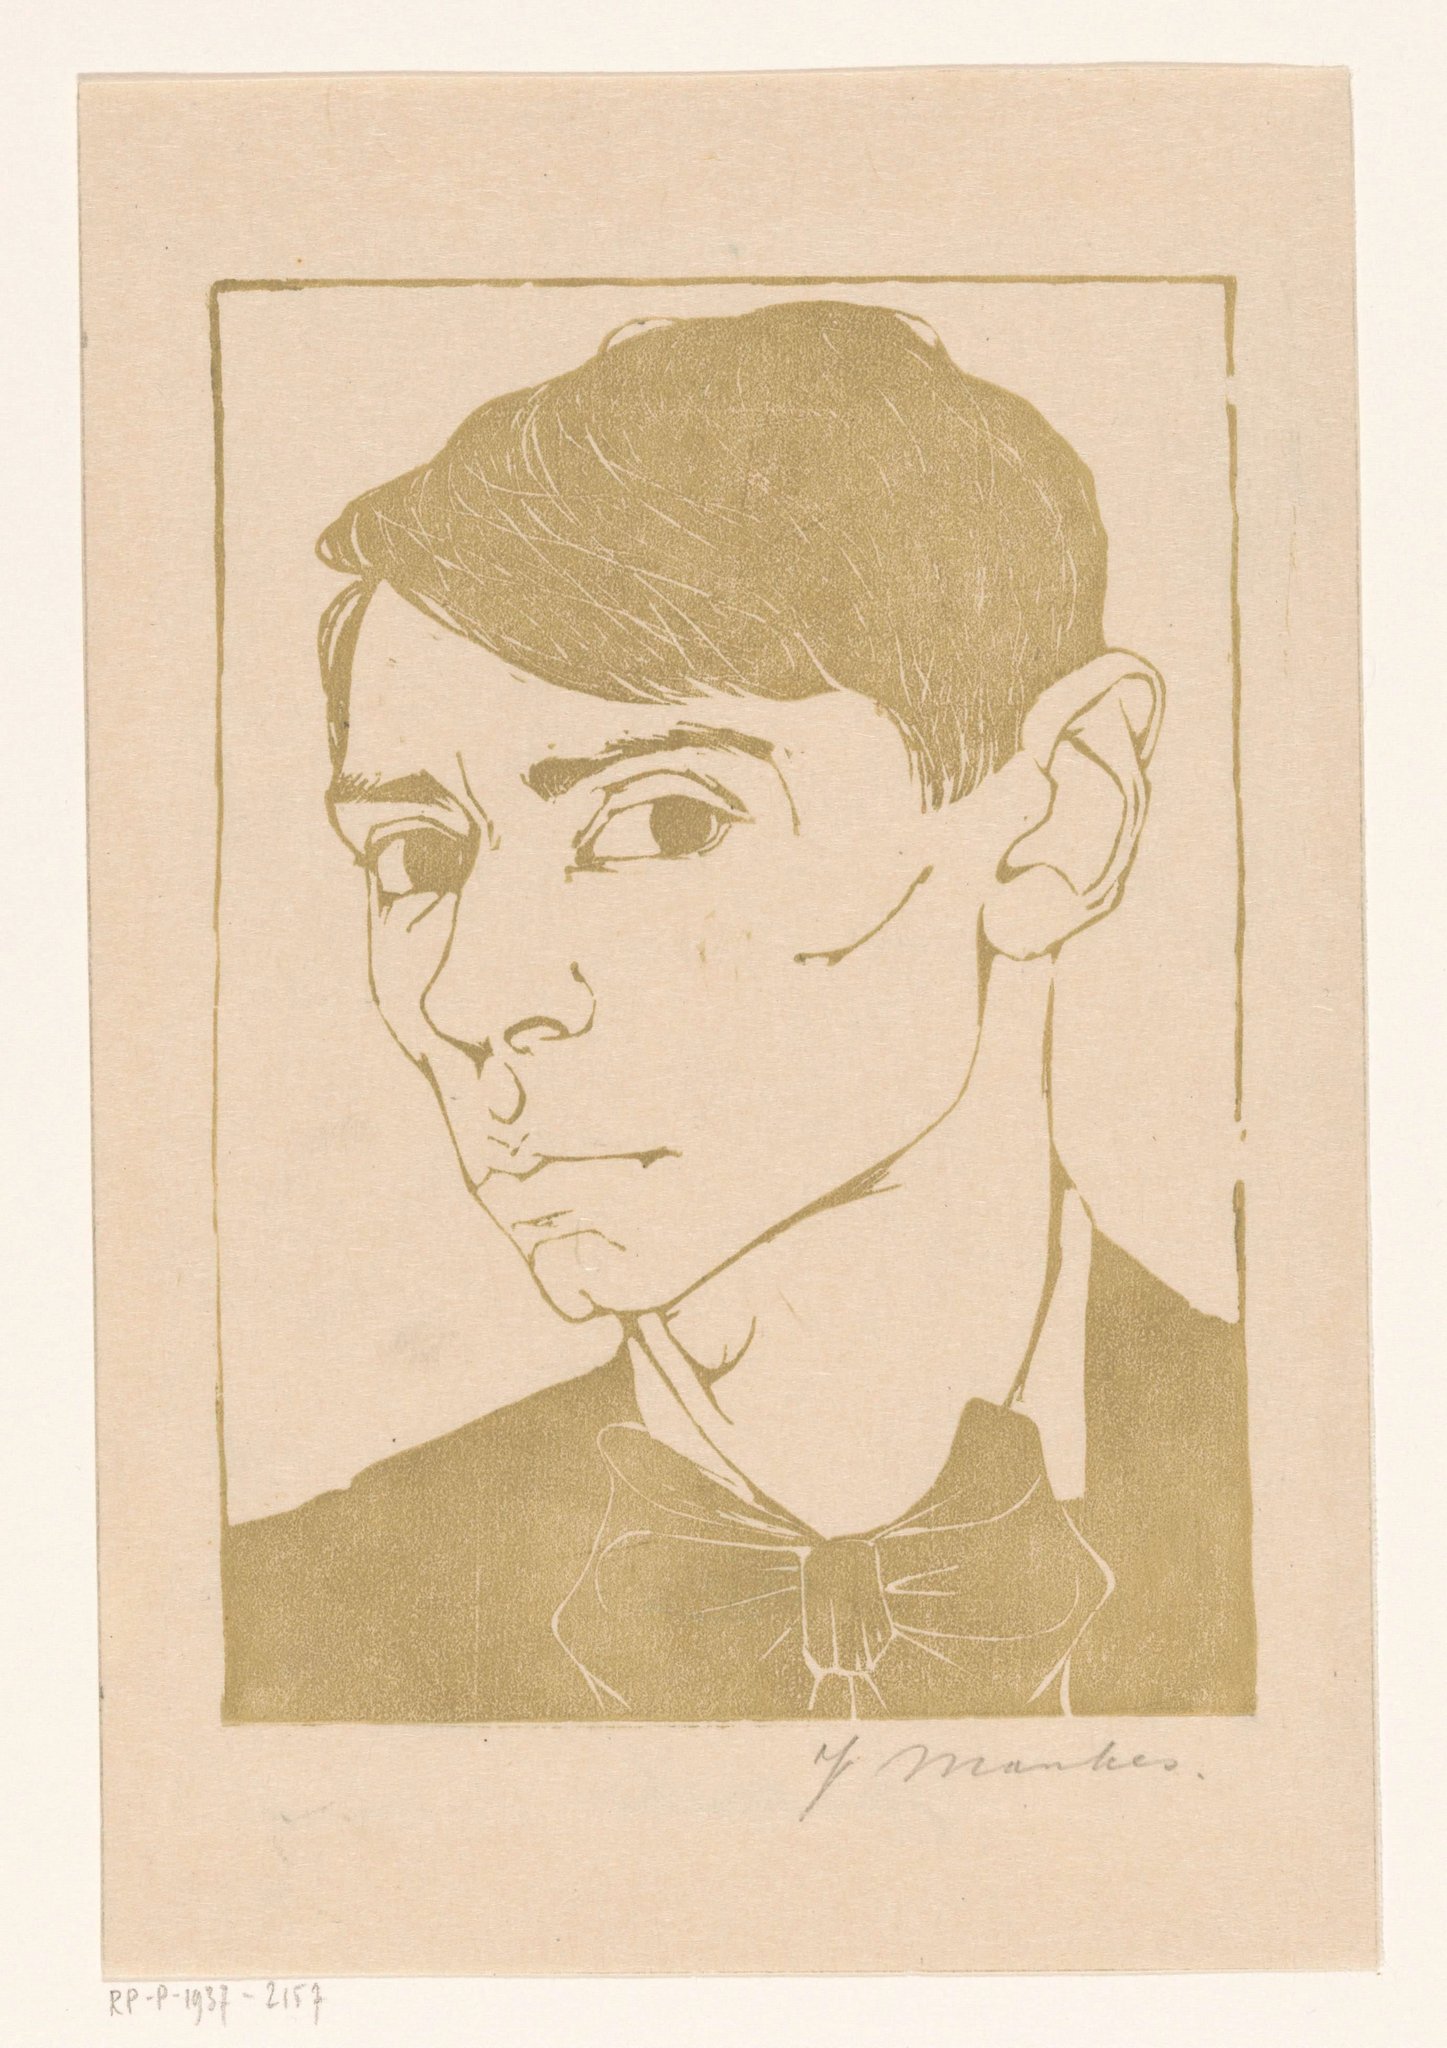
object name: print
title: Zelfportret met vlinderdas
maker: jan mankes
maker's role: draughtsman, painter, print maker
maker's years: 1889-1920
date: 1913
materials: paper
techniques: woodcut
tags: painter, print maker, draughtsman, jan mankes, neck-gear ~ clothing (with name), portrait, self-portrait of artist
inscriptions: collector's mark: Lugt 2760, collector's mark: Lugt 2228